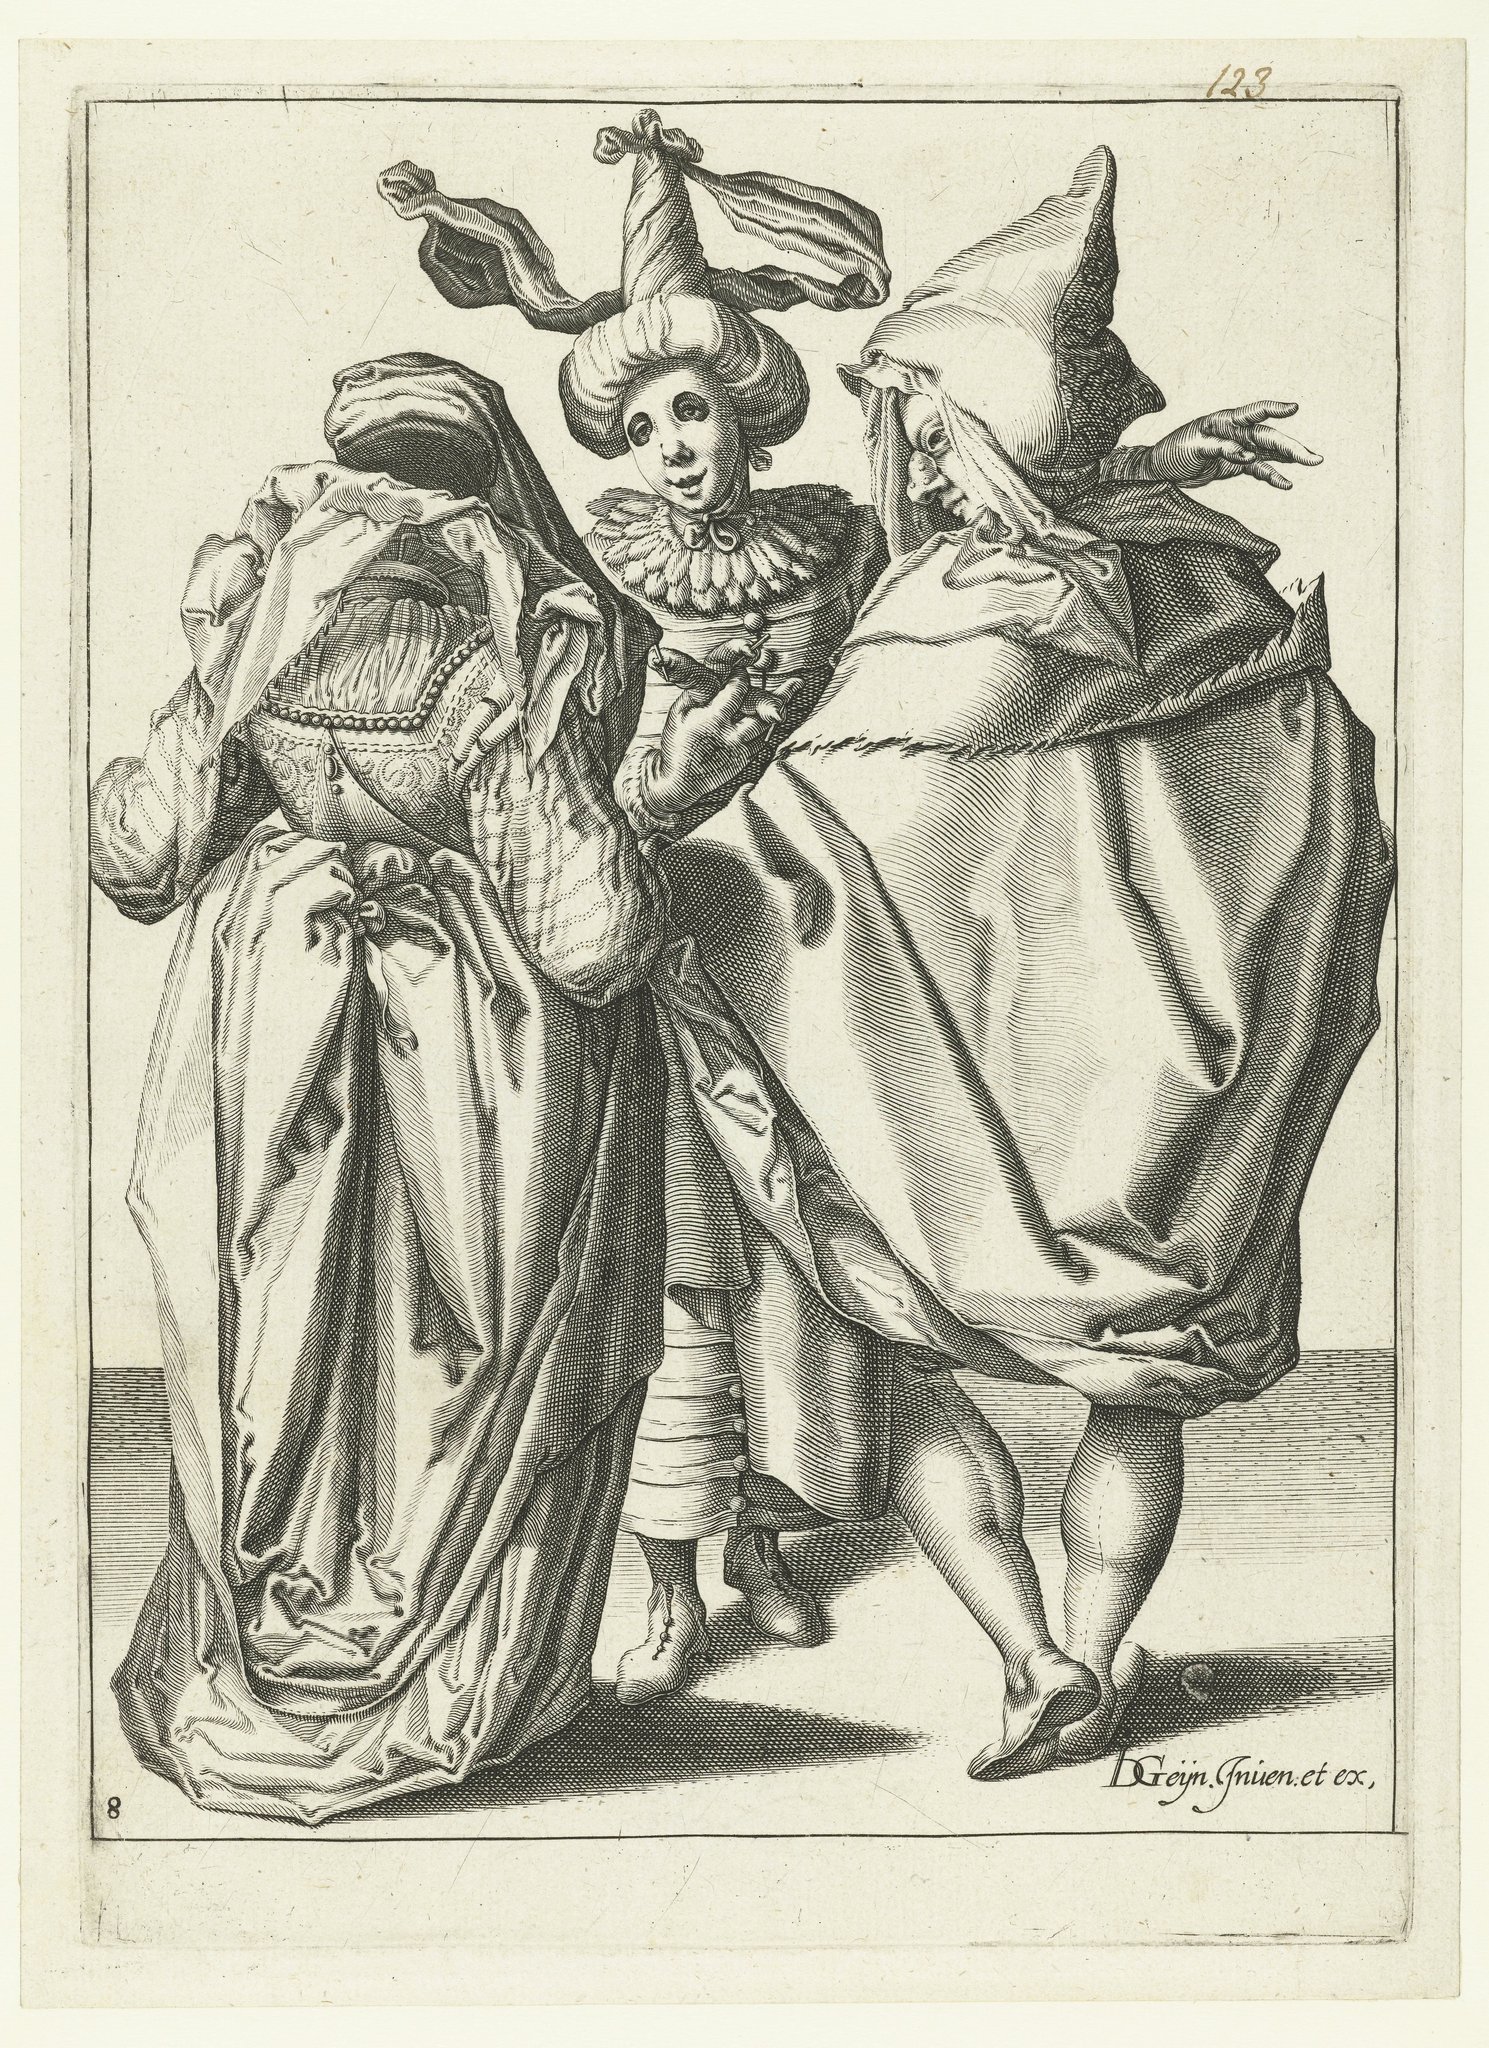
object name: print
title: De maskerades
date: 1595-1596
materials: paper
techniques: engraving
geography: netherlands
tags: mask, head-gear: hat (+ men's clothes), masquerade, masked ball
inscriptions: collector's mark: Lugt 2228a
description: Een feestelijke geklede vrouw en een man in een cape - beiden op de rug gezien - staan voor een gemaskerde jongeman met een tulband op; deze laatste strekt zijn linkerarm uit in een weids gebaar. Deze prent is onderdeel van een serie van tien genummerde prenten: een titelprent en negen prenten waarop twee of drie gemaskerde en/of verklede figuren ten voeten uit zijn weergegeven.